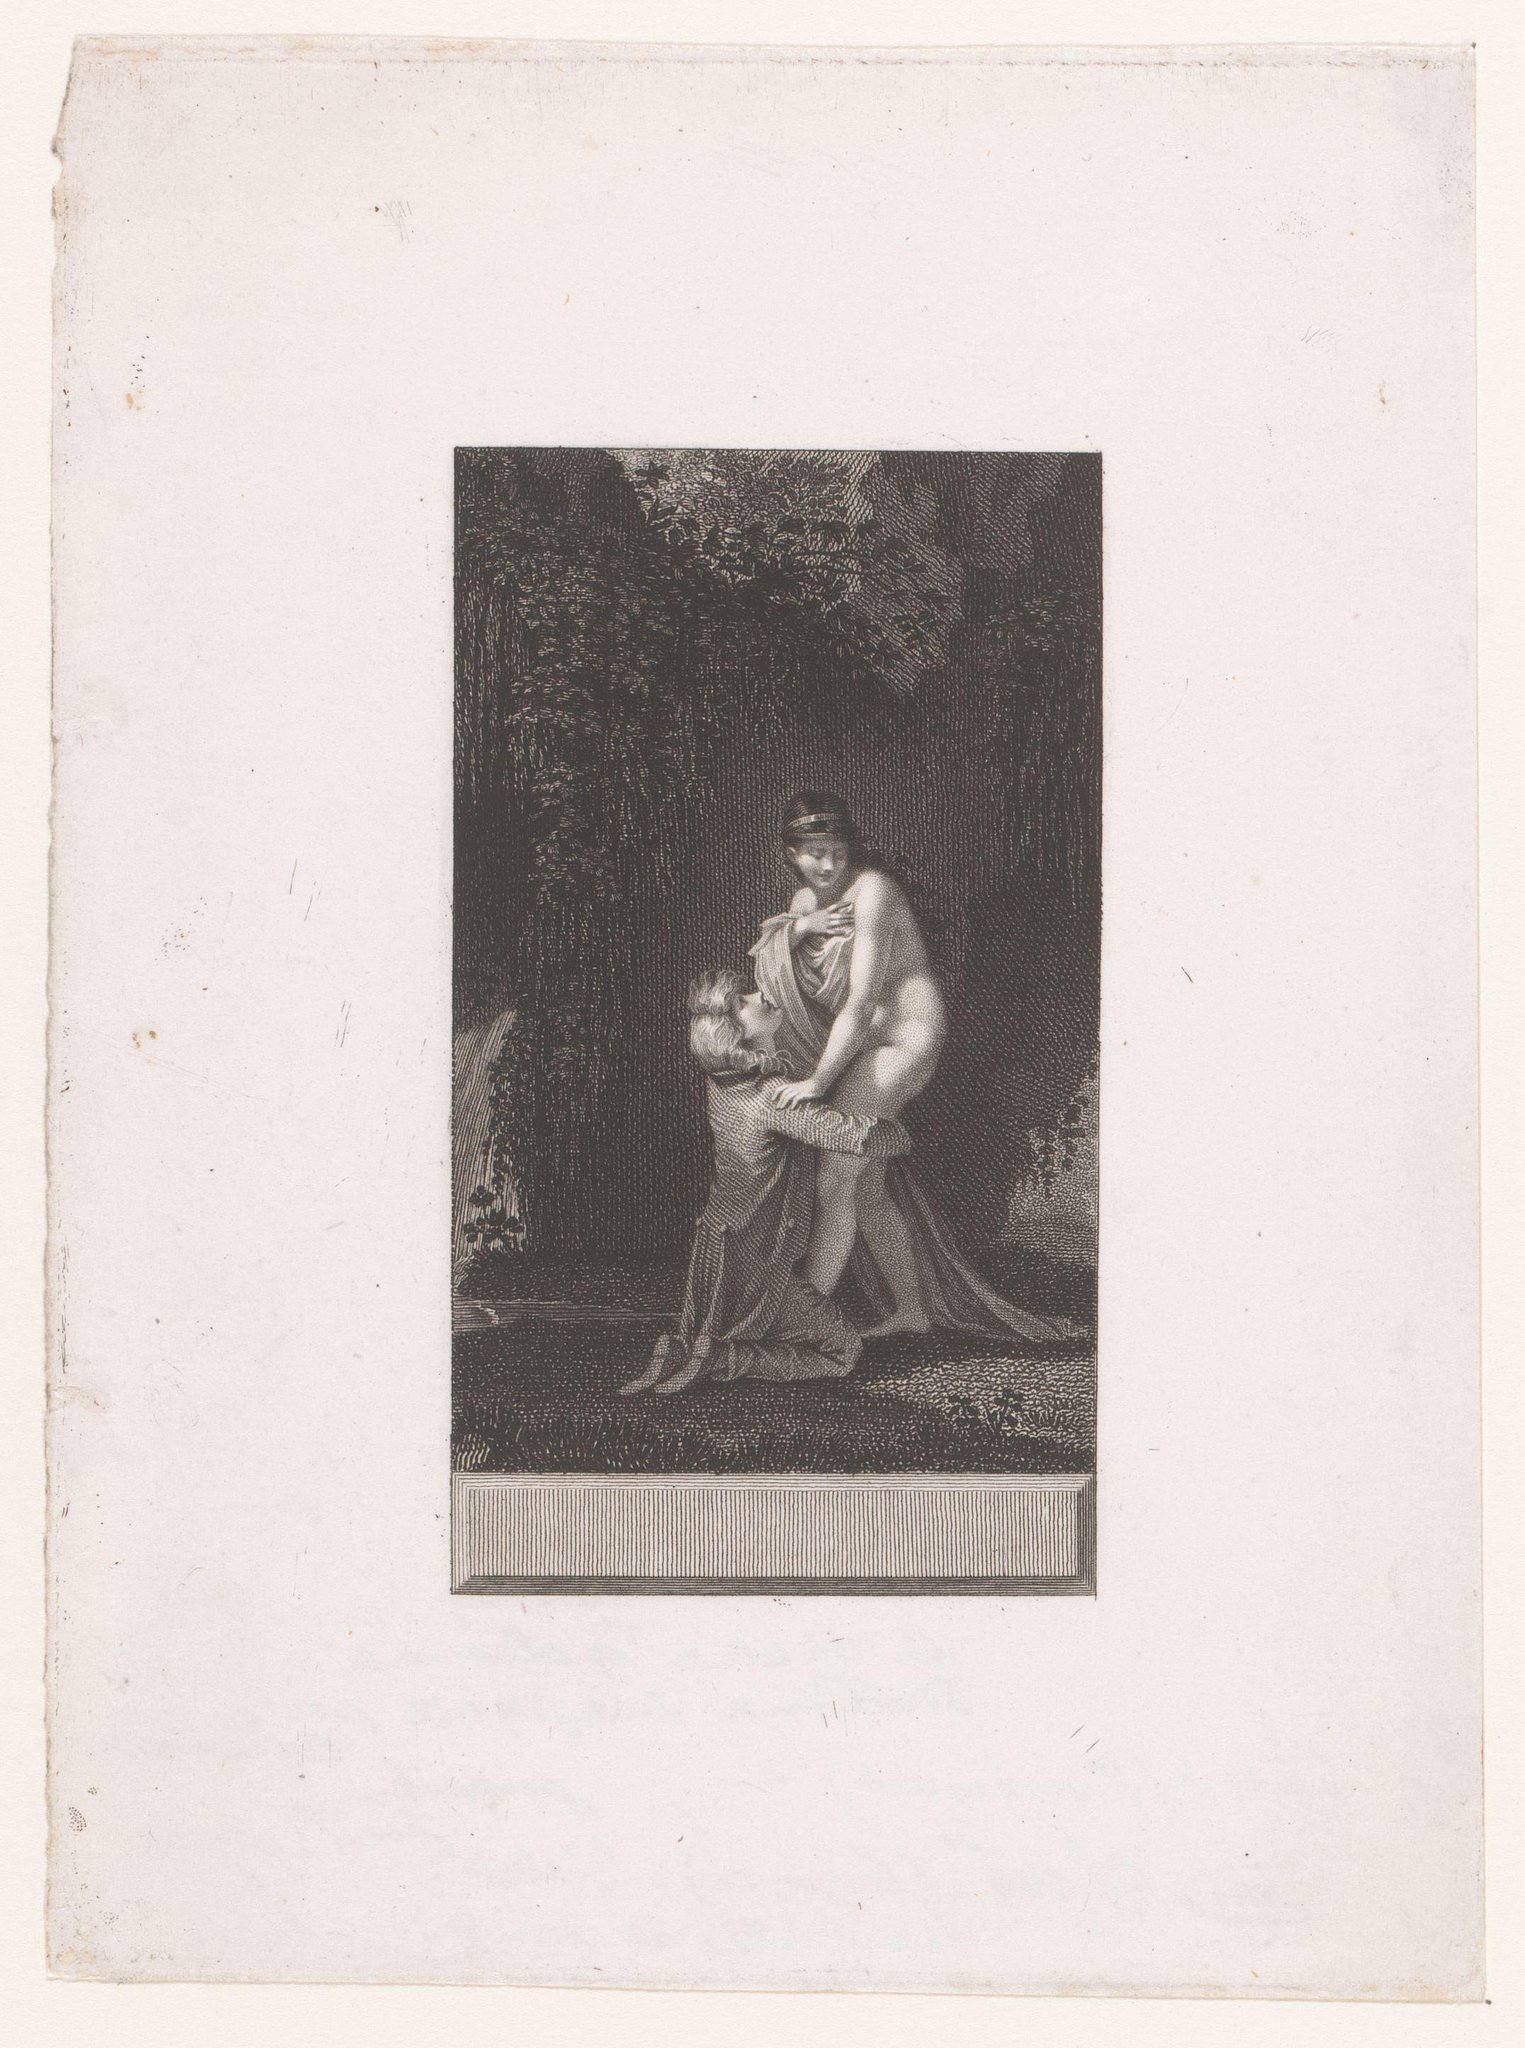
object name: print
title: Stellina en Edouard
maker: barthélémy joseph fulcran roger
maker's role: print maker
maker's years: 1767-1841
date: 1799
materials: paper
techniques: engraving, etching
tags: literary characters and objects, cave, grotto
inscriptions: collector's mark: Lugt 2228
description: Scène uit "La Tribu Indienne" van Lucien Bonaparte.